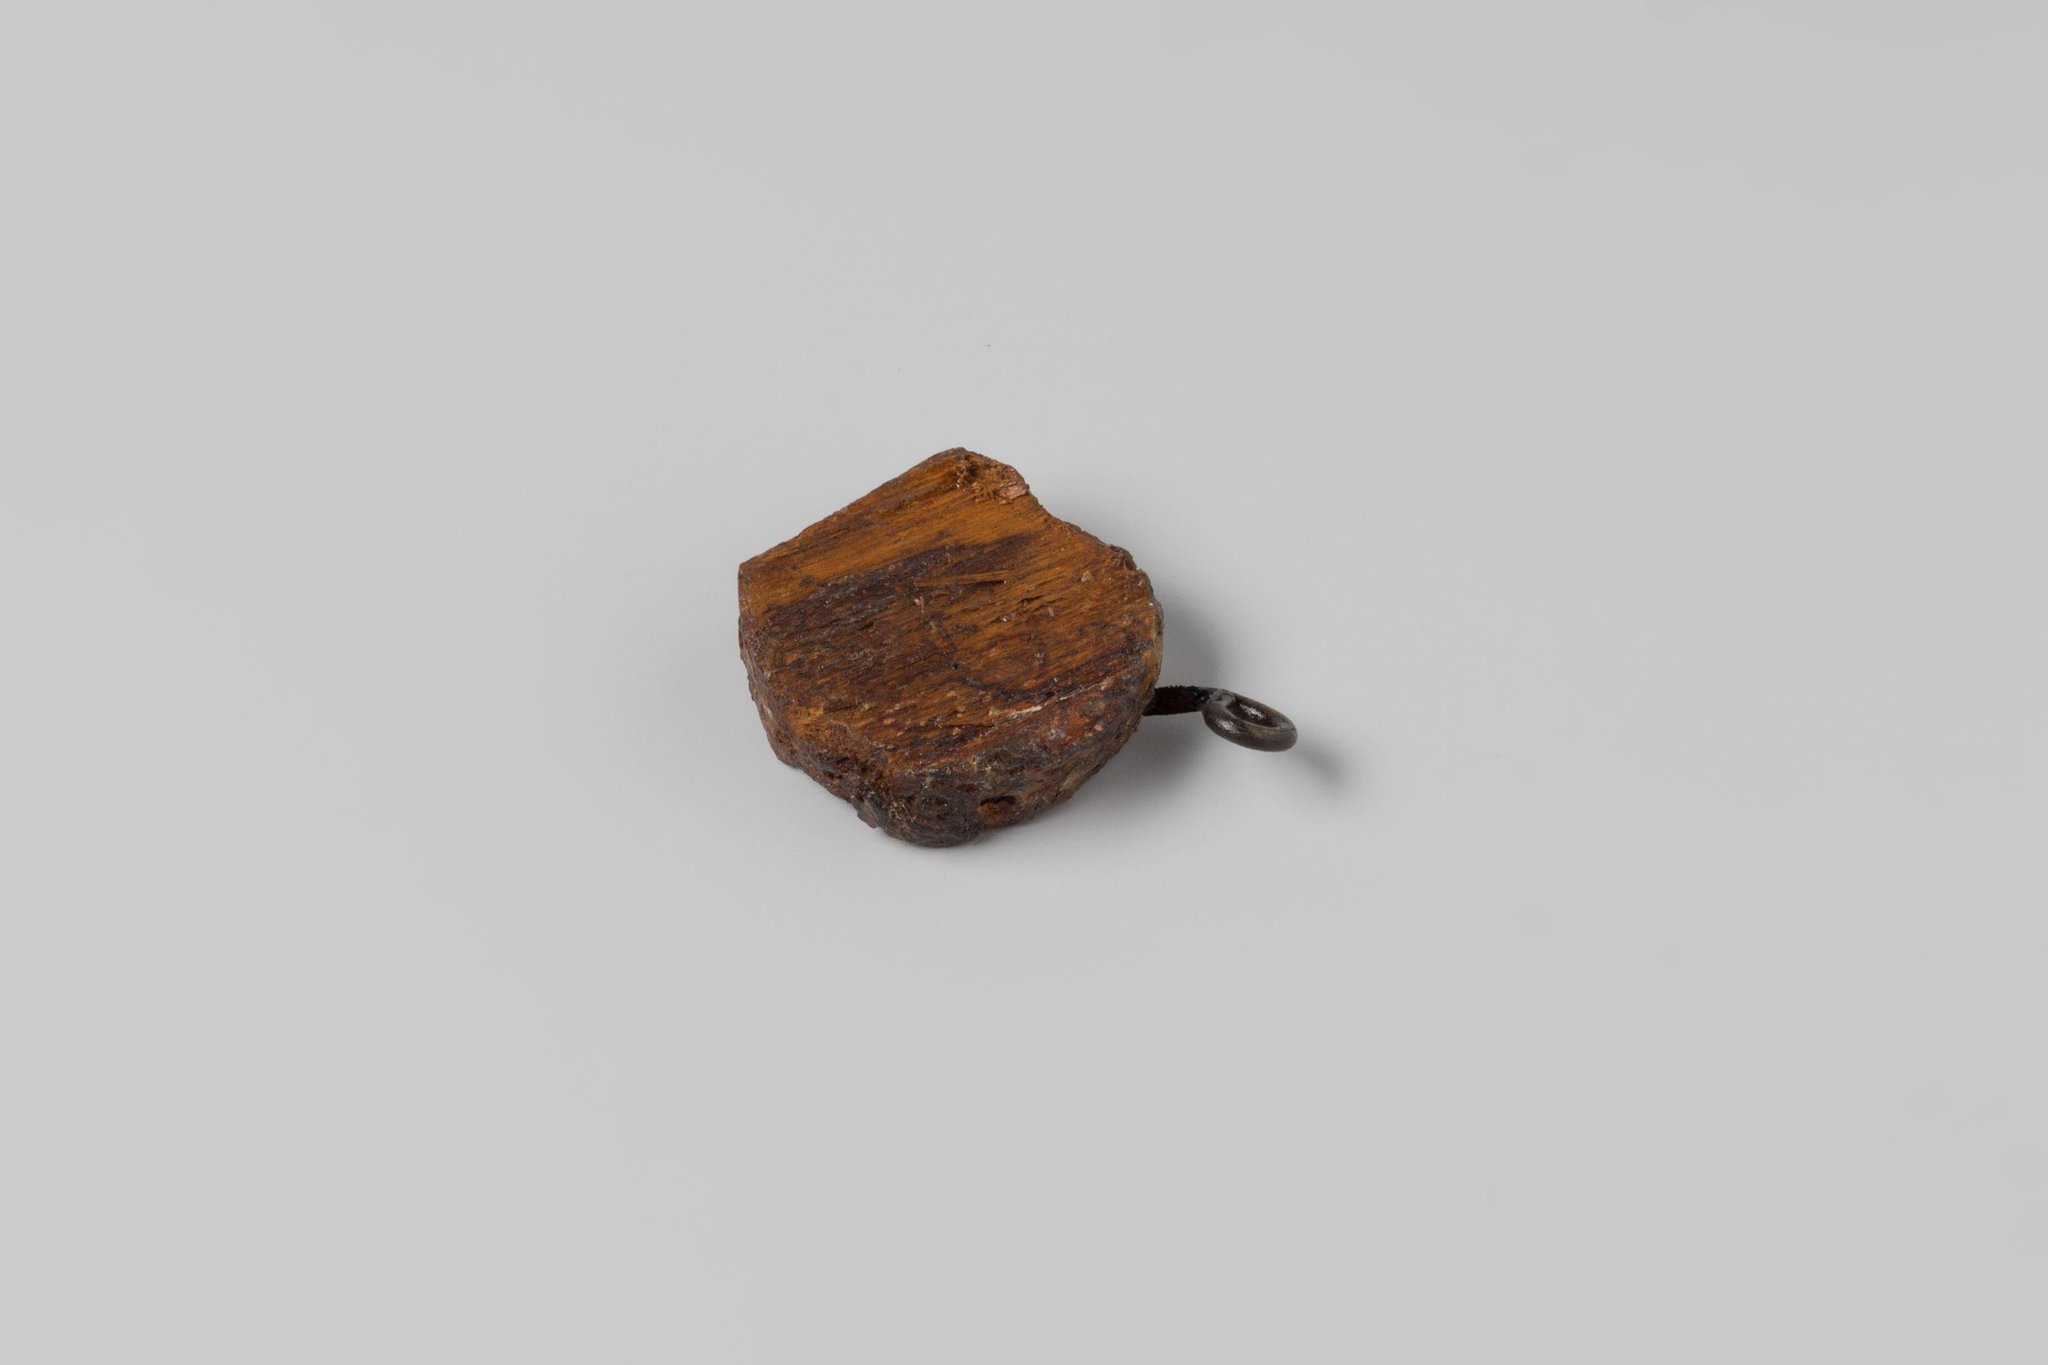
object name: powder horn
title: Fragment kruithoorn uit het wrak van de Oost-Indiëvaarder Hollandia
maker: Anonymous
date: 1700-1743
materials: bone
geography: netherlands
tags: verenigde oostindische compagnie, hollandia (schip), annet